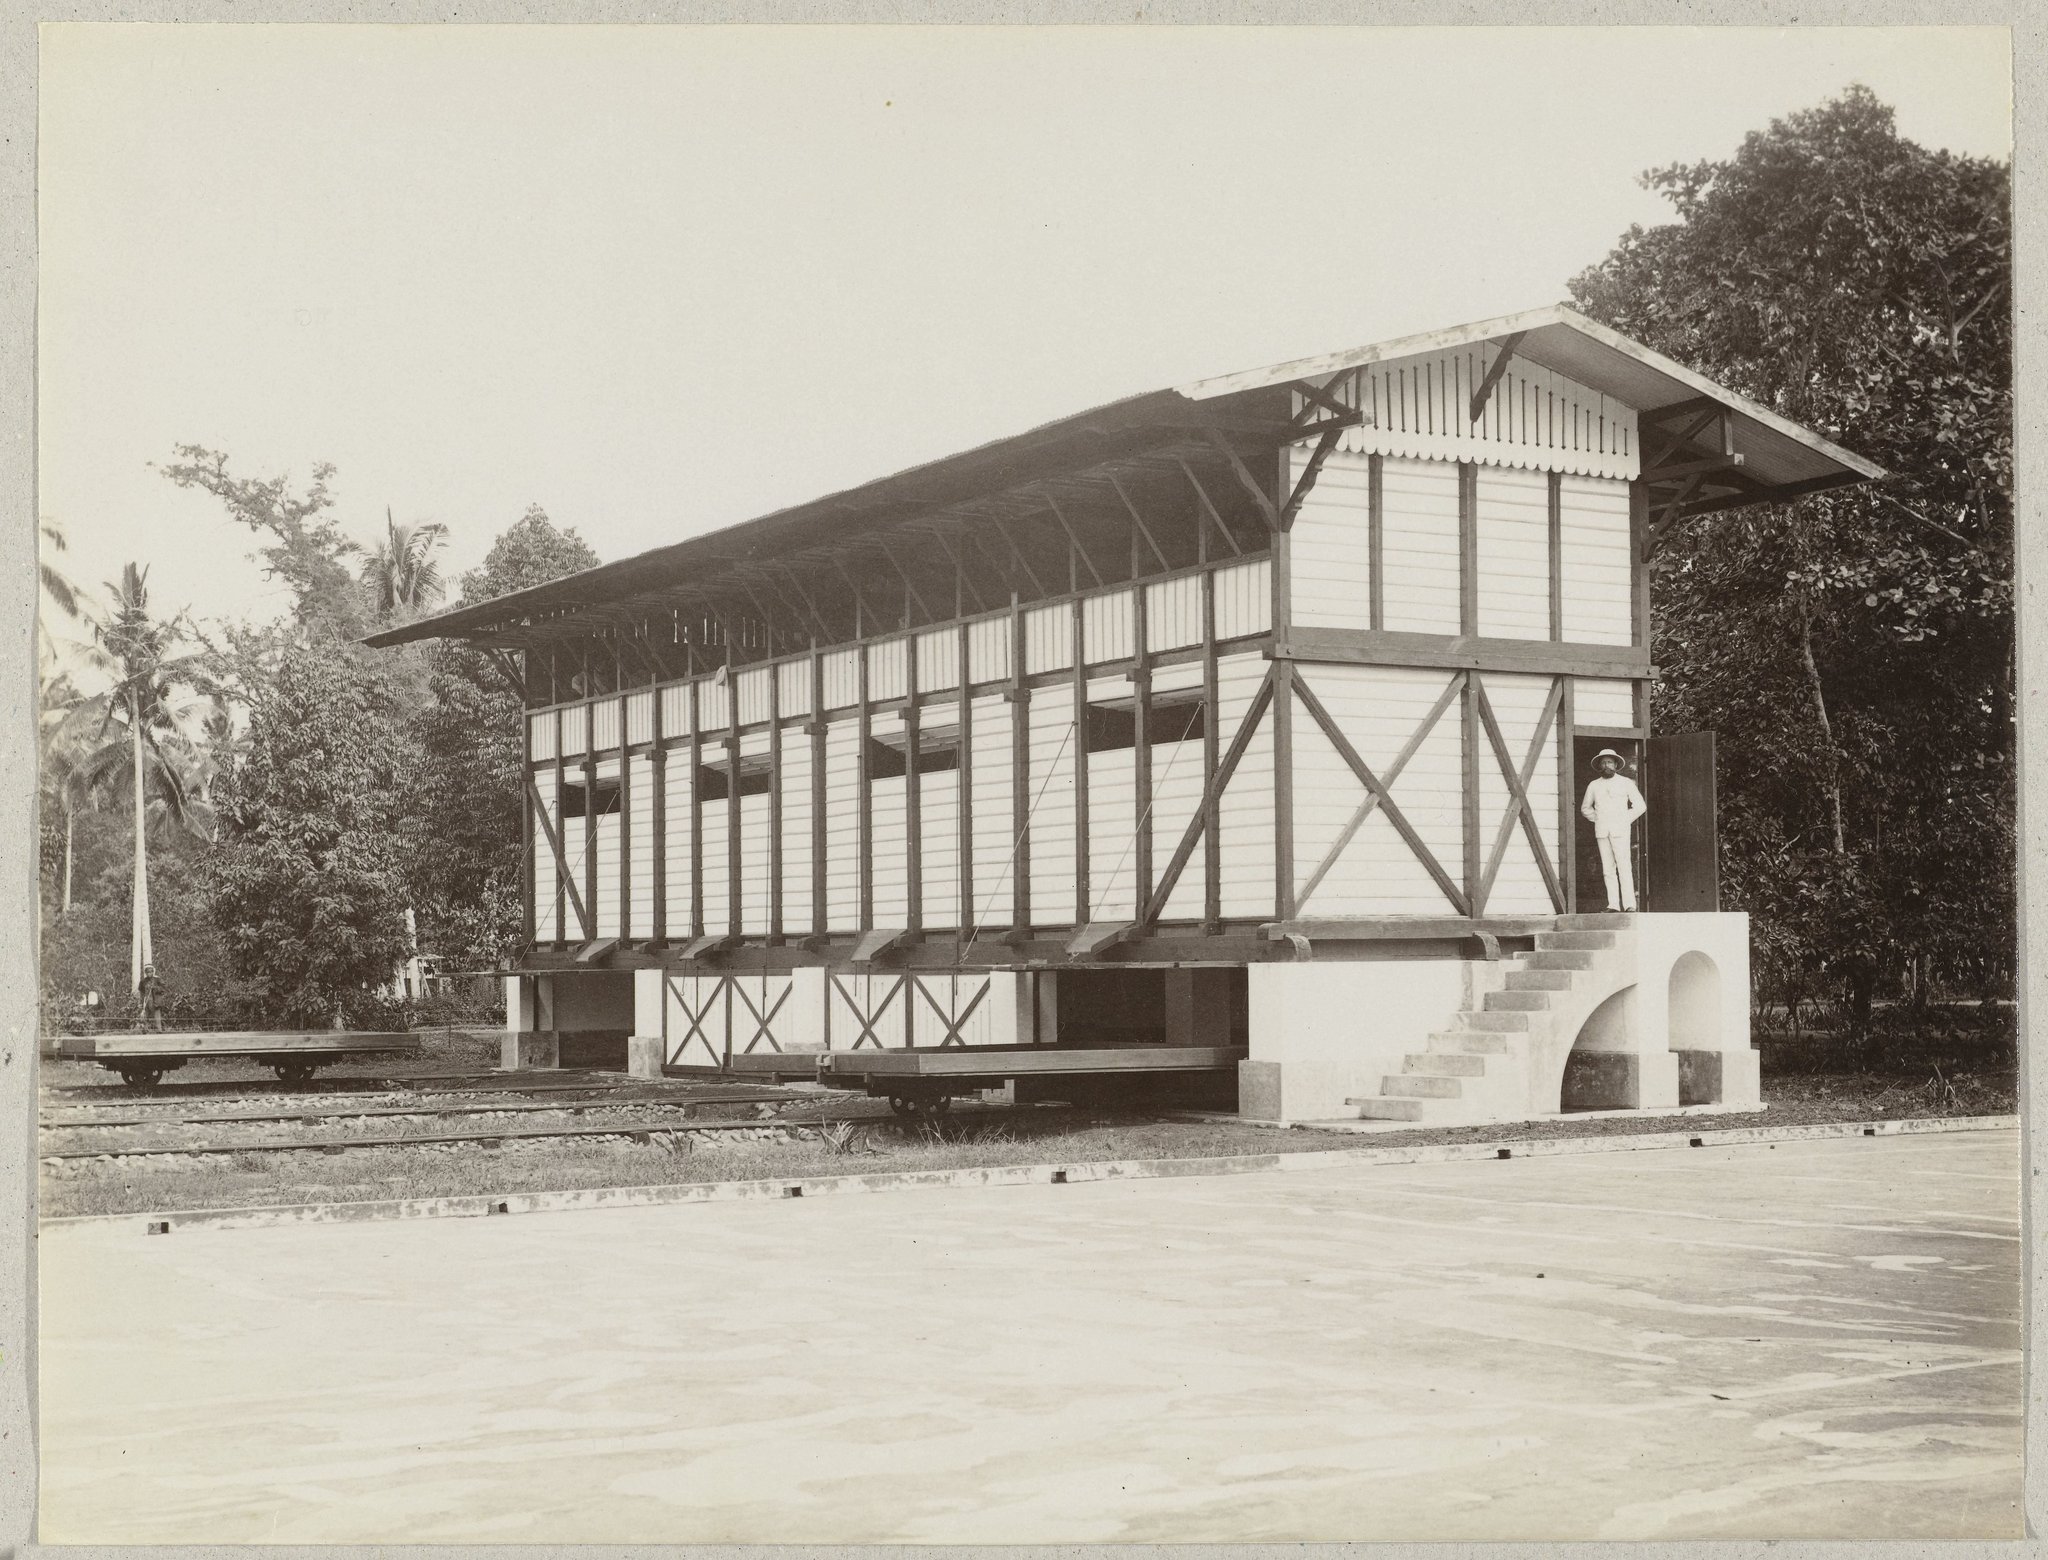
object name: photograph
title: Europeaan in de deuropening van een opslag voor oogst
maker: christiaan benjamin nieuwenhuis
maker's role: publisher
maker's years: 1863-1922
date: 1891-1912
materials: paper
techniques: albumen print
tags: storage space, railway, train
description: Een hal waar de oogst van het veld per spoor binnen wordt gereden. Bij de deur 'poseert een man in een 'tropenuniform'.